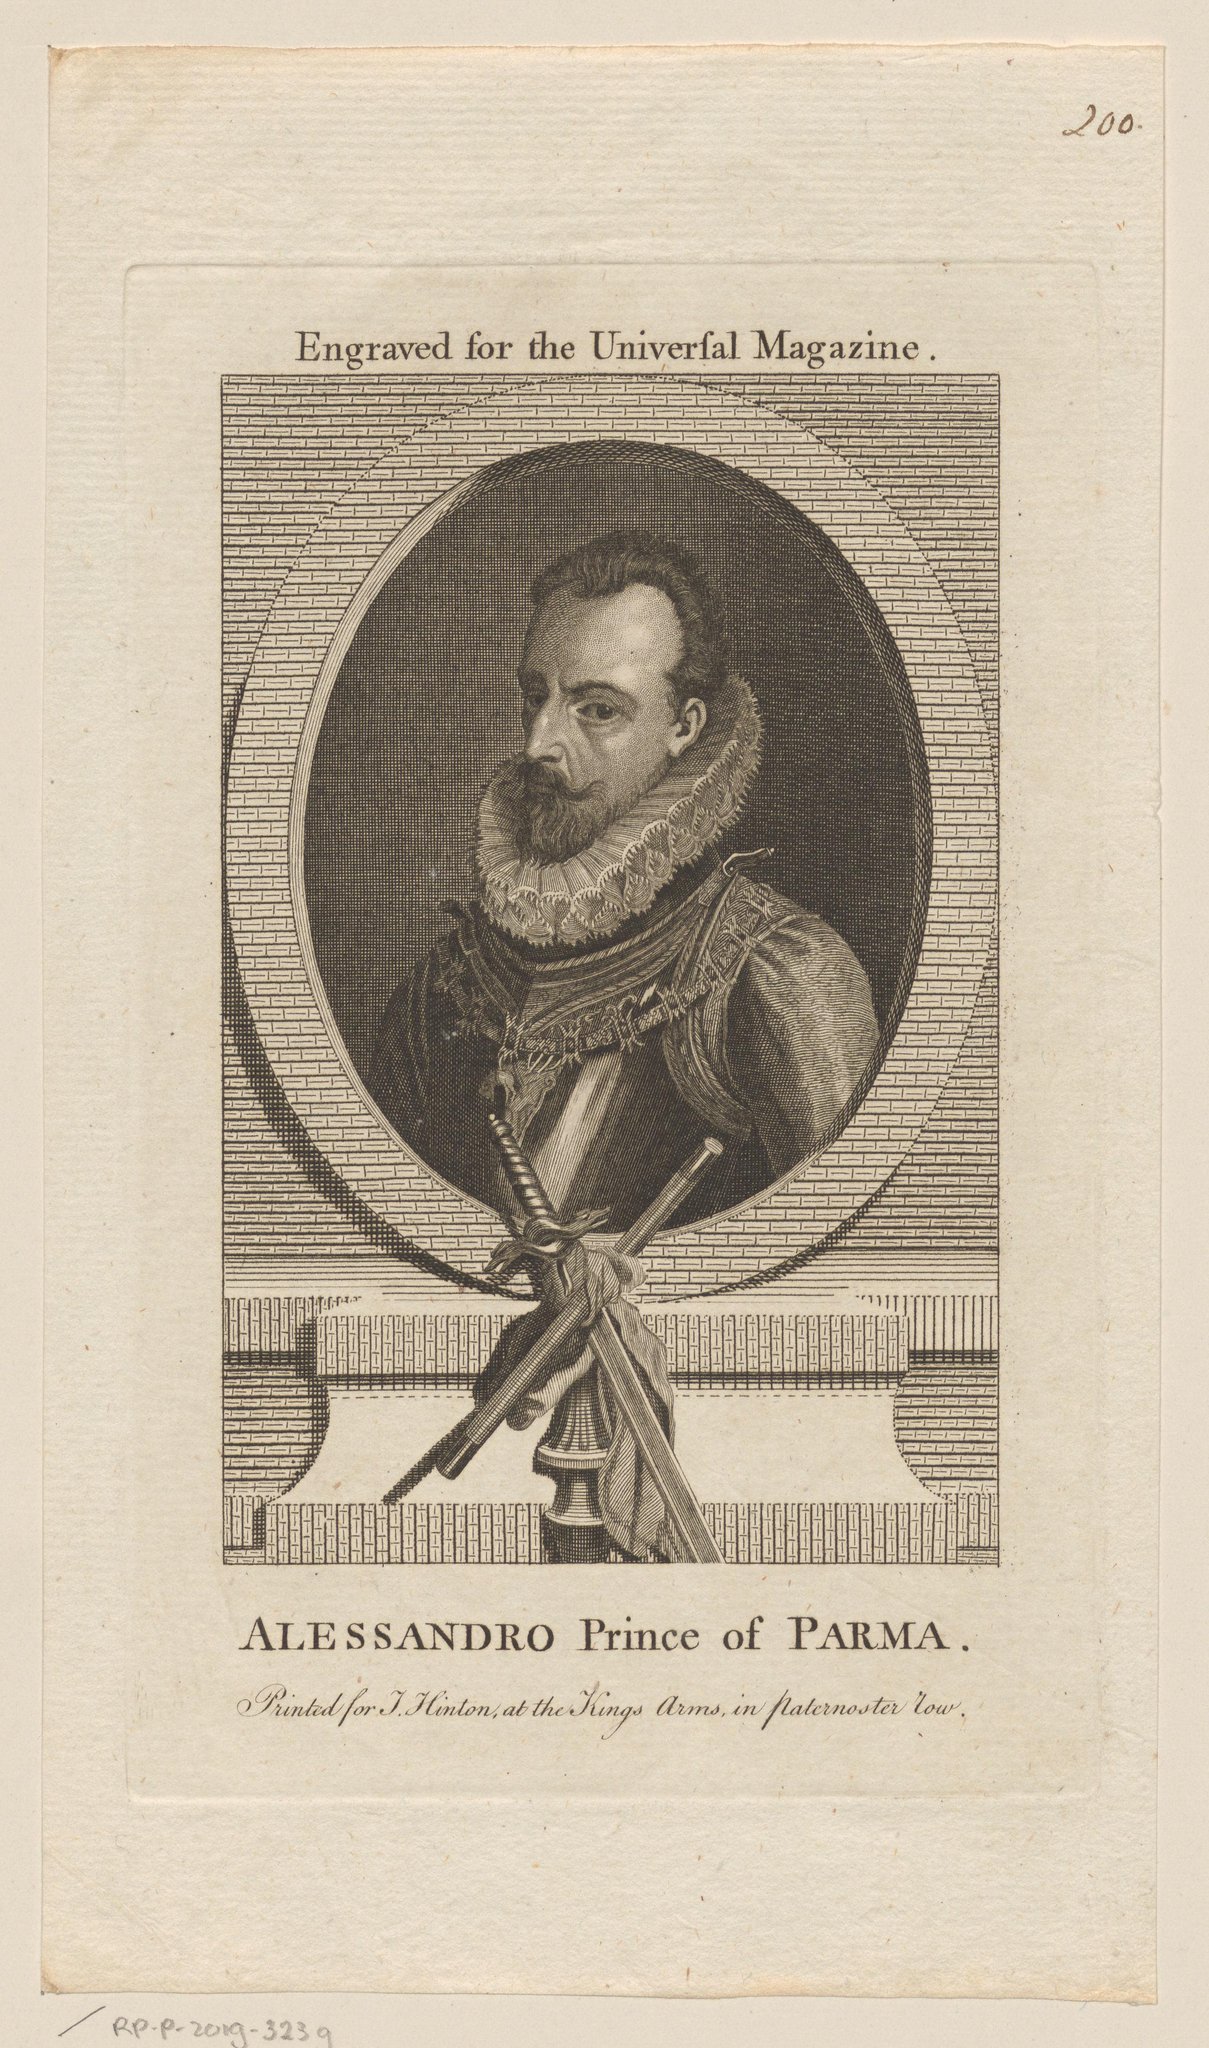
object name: print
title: Portret van Alexander Farnese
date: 1747-1781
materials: paper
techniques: etching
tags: rome, alessandro farnese (landvoogd van de nederlanden en hertog van parma en piacenza), historical persons, knighthood order of the golden fleece - insignia of a knighthood order, e.g.: badge, chain (with name of order), baton of general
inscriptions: inscription: ‘200.’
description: Prent uit: The Universal Magazine of Knowledge and Pleasure. Londen: John Hinton, later William Bent, 1747-1814.